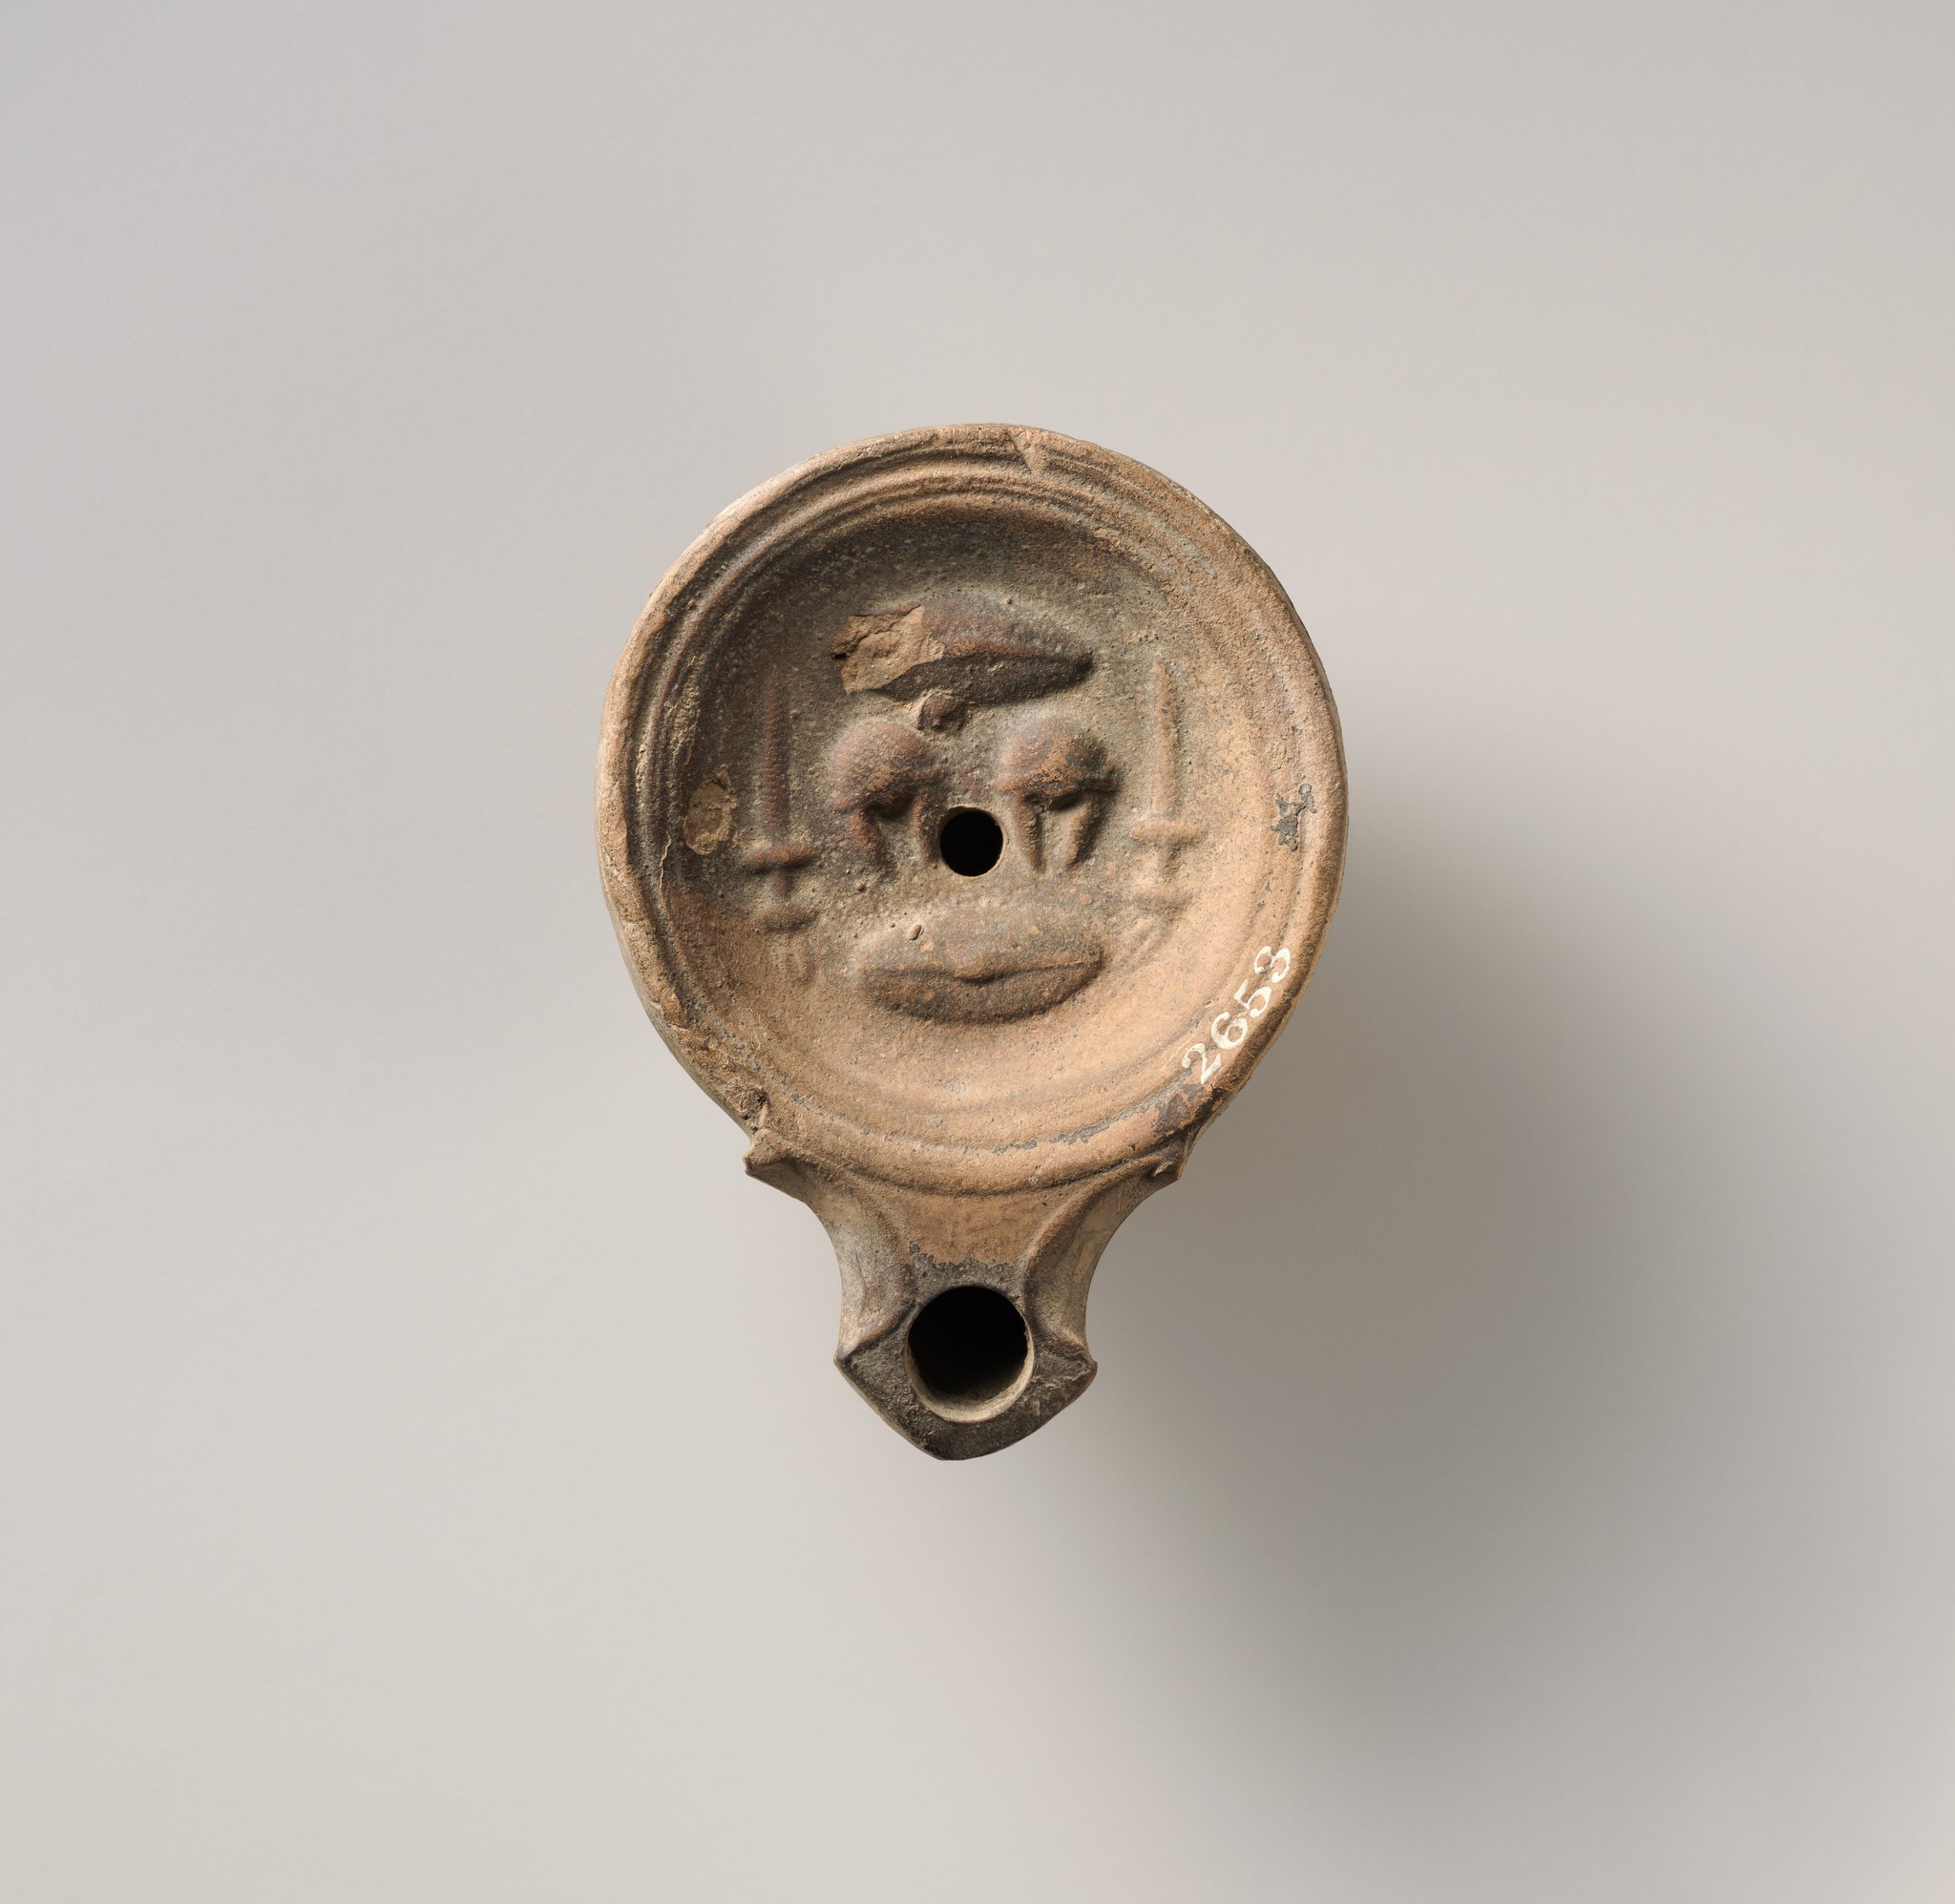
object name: lamp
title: Terracotta oil lamp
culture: roman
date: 34-66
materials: terracotta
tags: helmets,shields,swords